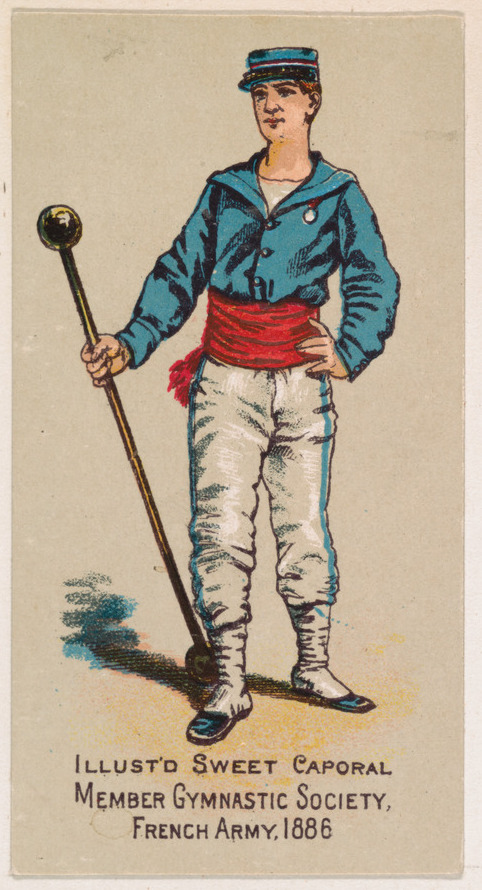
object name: print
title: Member, Gymnastic Society, French Army, 1886, from the Military Series (N224) issued by Kinney Tobacco Company to promote Sweet Caporal Cigarettes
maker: kinney brothers tobacco company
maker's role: publisher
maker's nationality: american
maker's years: 1869-2011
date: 1888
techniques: color lithograph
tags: army,men,athletes